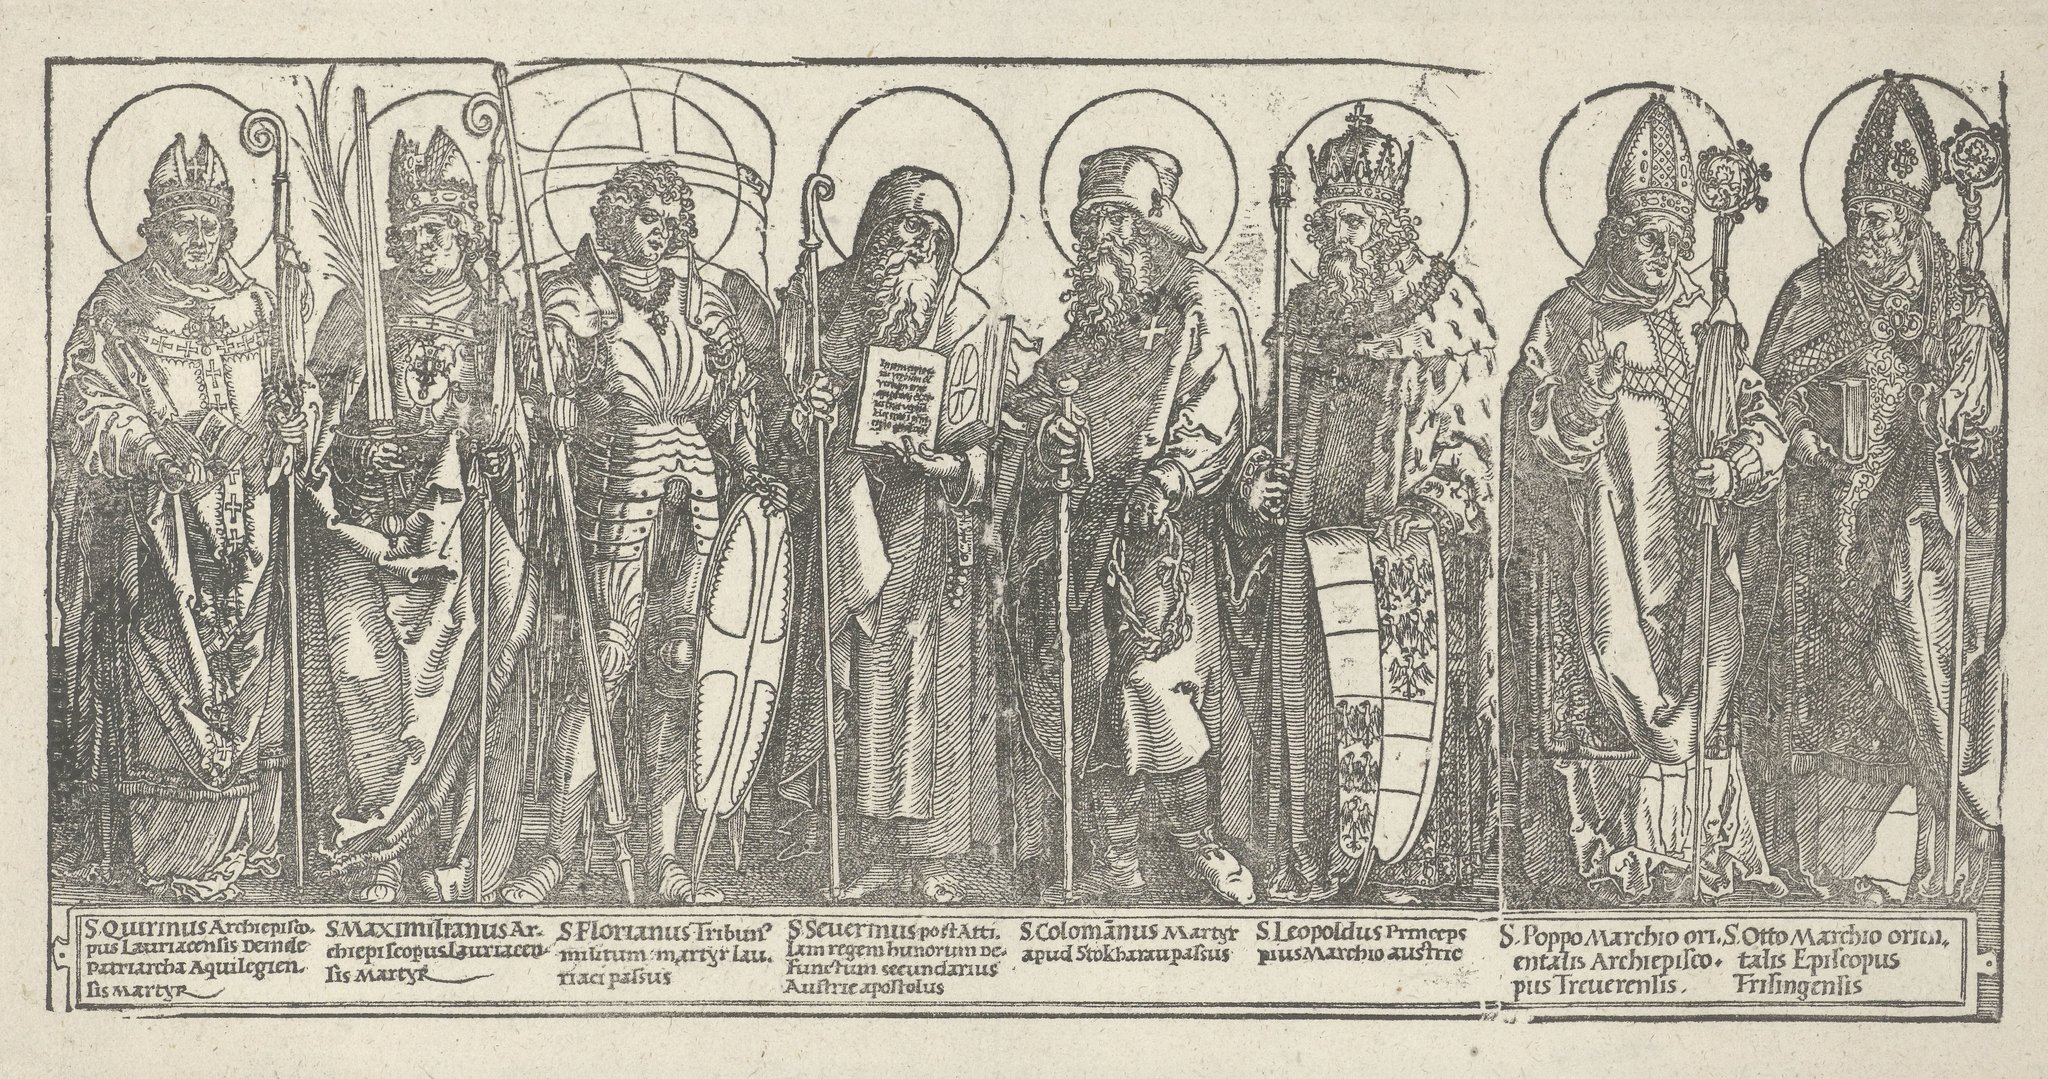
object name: print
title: De beschermheiligen van Oostenrijk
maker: albrecht dürer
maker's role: draughtsman, painter, print maker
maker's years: 1471-1528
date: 1515-1517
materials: paper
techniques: woodcut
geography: nuremberg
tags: the soldier martyr florian of lorch; possible attributes: bucket (pitcher), lance with banner, millstone, palm-branch, shield (with cross), sword, male saints (with name)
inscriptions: collector's mark: Lugt 2228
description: Op een rij, ten voeten uit, de Heilige Quirinus (in bisschopskleding en met boek), Maximiliaan (in bisschopskleding en met palmtak en zwaard), Florian (in harnas en met schild), Severinus van Oostenrijk (in habijt en met boek), Colomannus (in pelgrimskleding en met krans), Leopold (in hermelijnen mantel en met schild), Poppo (in bisschopskleding, een zegenend gebaar makend) en Otto (in bisschopskleding en met boek). Onder de voorstelling bij elk van de figuren hun naam en een korte typering.